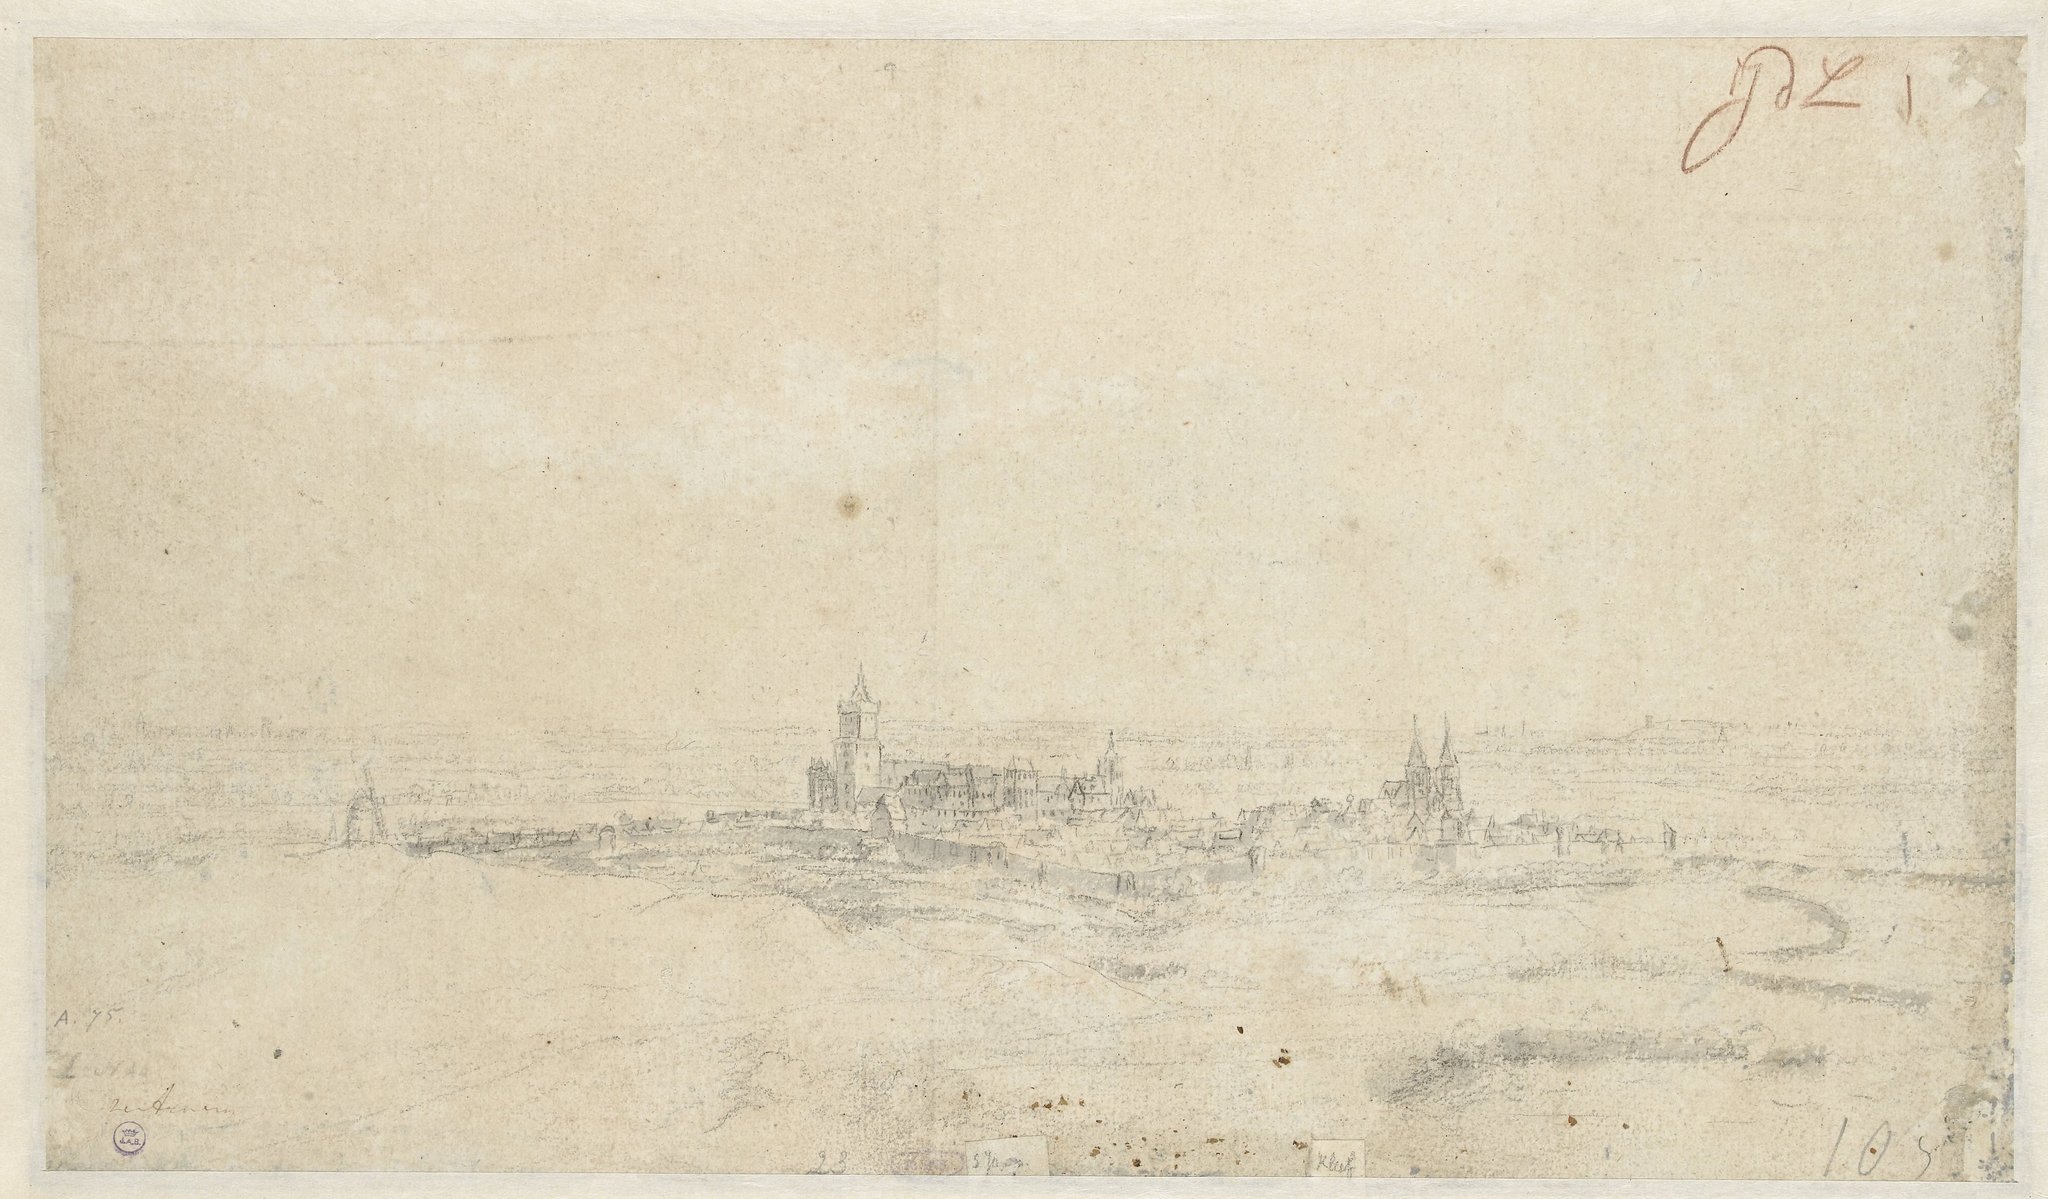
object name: drawing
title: Gezicht op de stad Kleve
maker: anthonie waterloo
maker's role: draughtsman, painter, print maker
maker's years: 1609-1690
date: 1619-1690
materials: chalk, paper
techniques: brush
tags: prospect of city, town panorama, silhouette of city, cleves